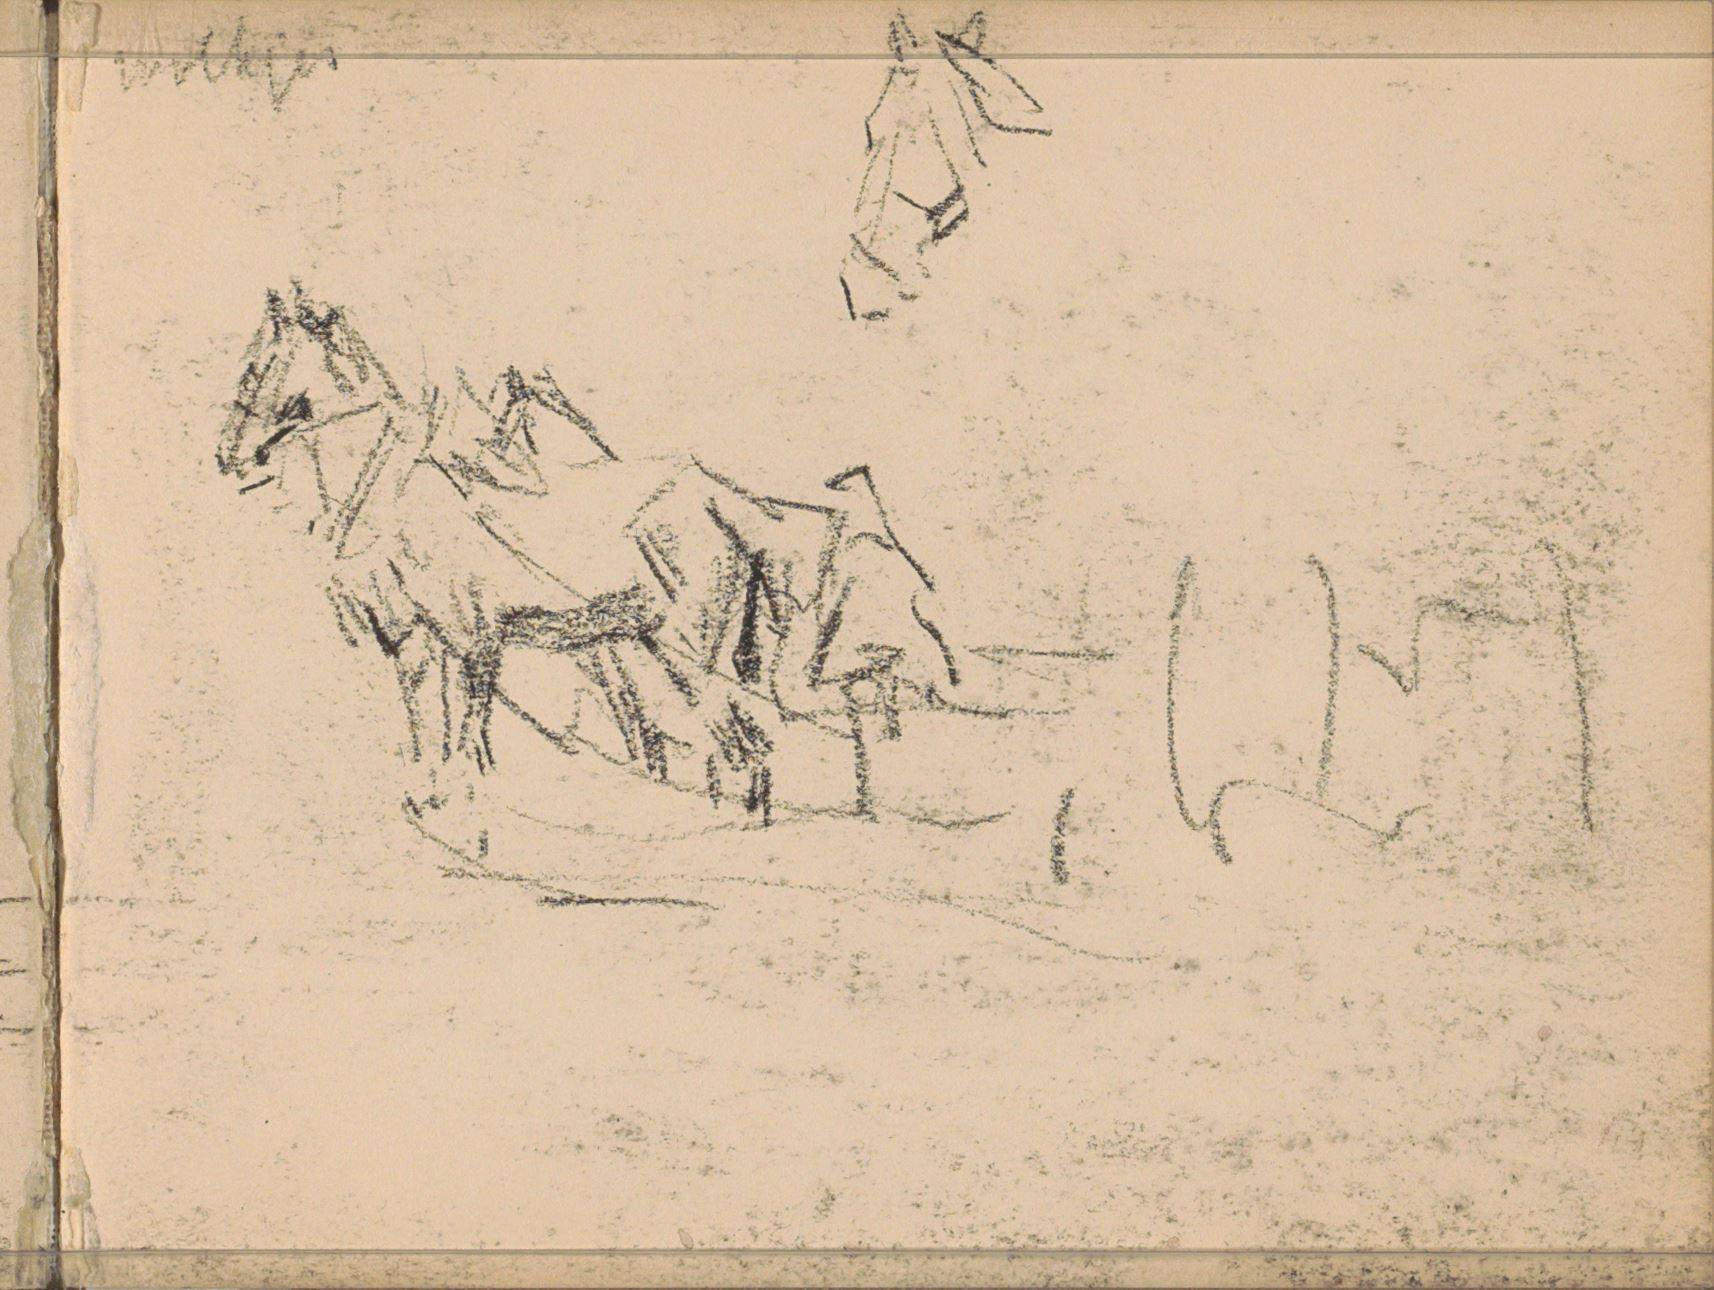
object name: sketchbook leaf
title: Aangespannen paarden en een paardenhoofd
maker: johan antonie de jonge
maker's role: draughtsman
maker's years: 1864-1927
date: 1881-1927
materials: chalk, paper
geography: south holland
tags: horse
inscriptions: annotation: ‘wolkjes’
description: Aangespannen paarden en een paardenhoofd. Blad 10 uit een schetsboek met 34 bladen.